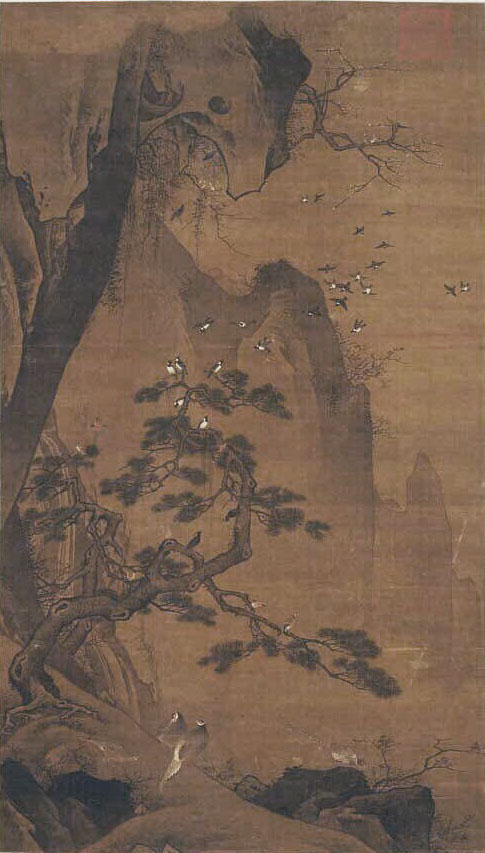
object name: hanging scroll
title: Landscape with Birds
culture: chinese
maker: unidentified artist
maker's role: artist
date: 1501-1600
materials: ink, silk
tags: birds,landscapes